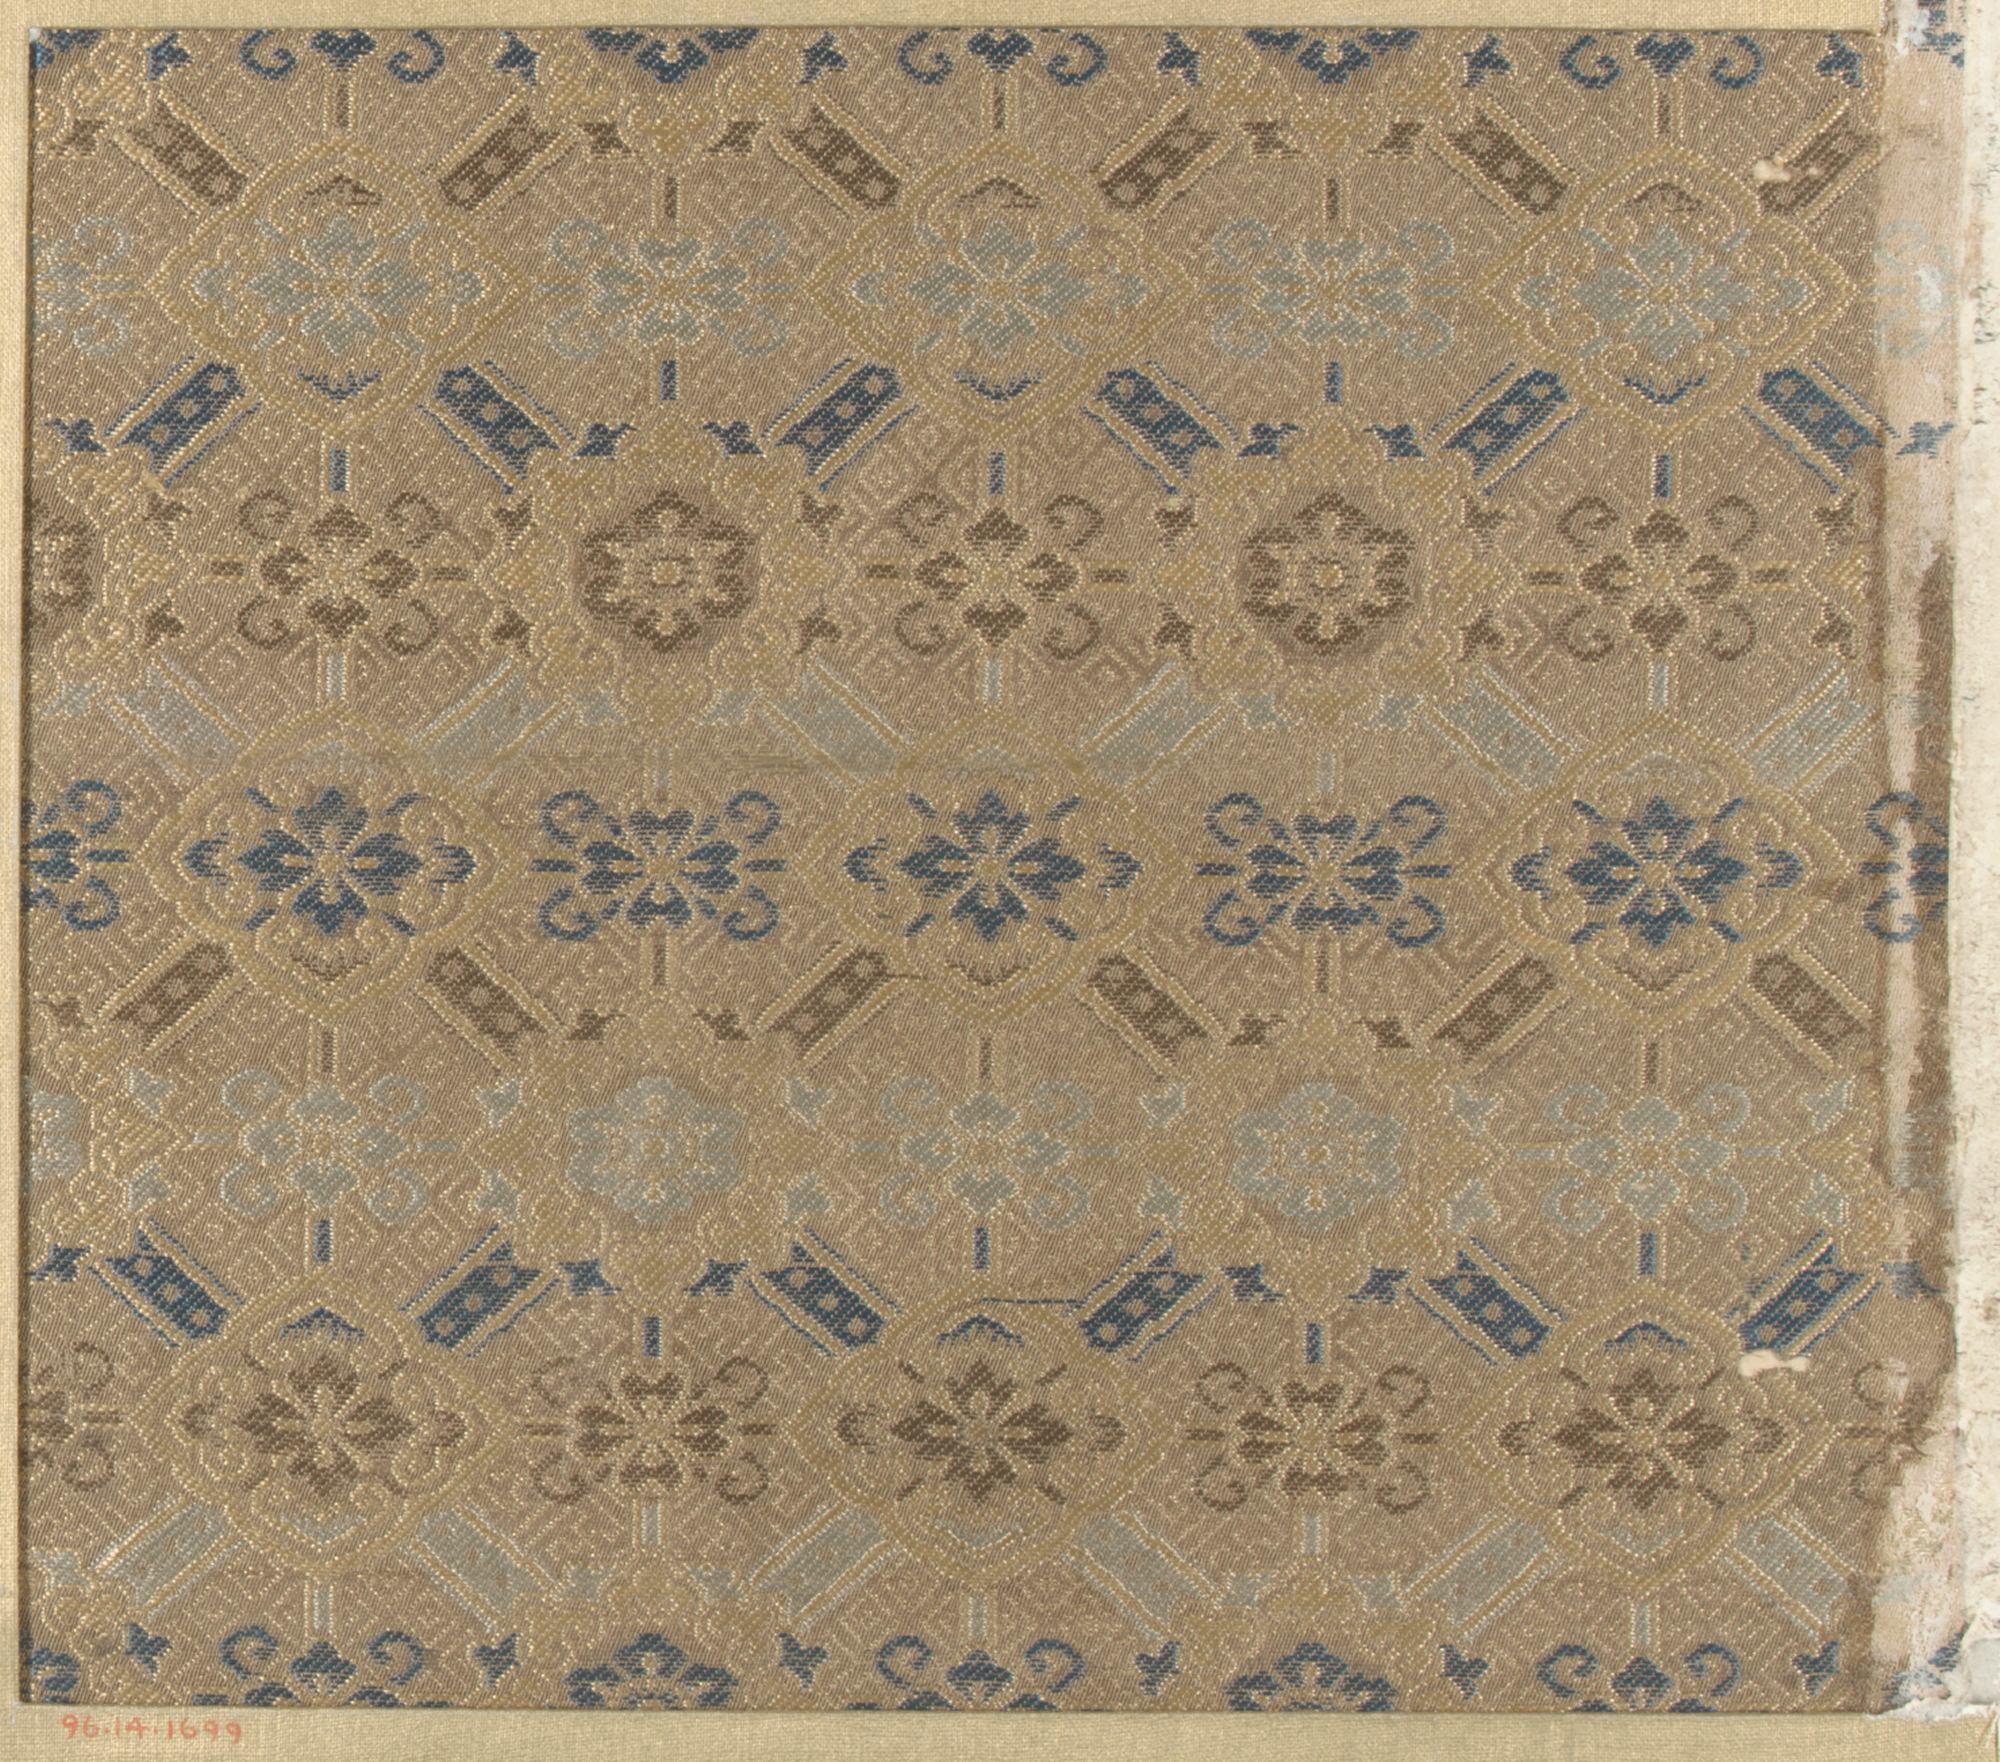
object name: piece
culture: japanese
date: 1701-1900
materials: silk